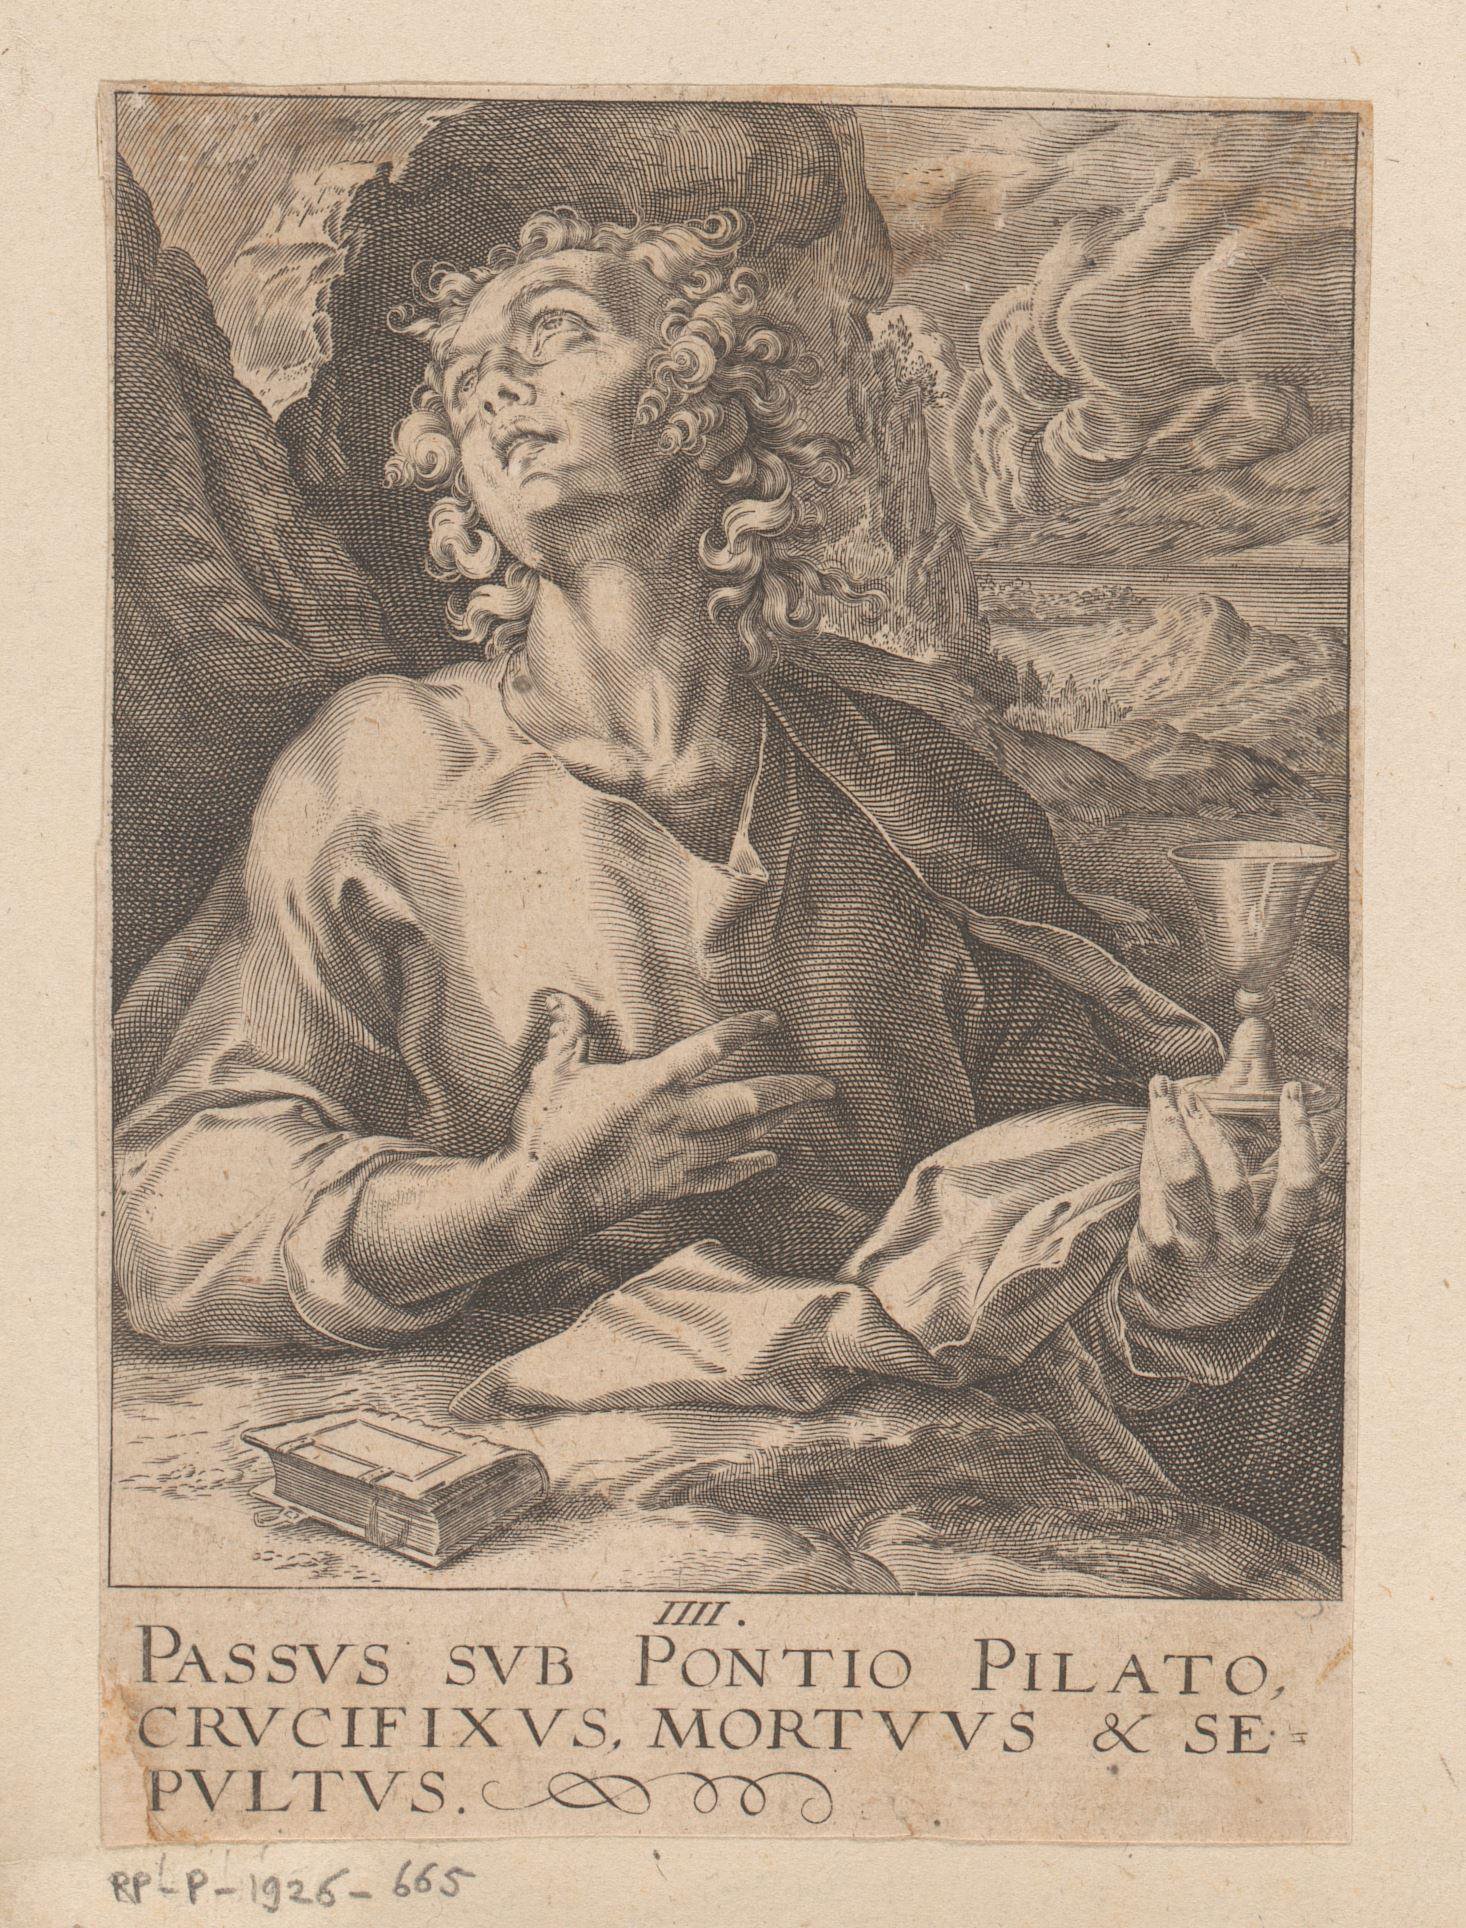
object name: print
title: Apostel Johannes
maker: jacques granthomme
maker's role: print maker, publisher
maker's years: 1550-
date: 1588-1622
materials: paper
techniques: engraving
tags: the apostle john the evangelist; possible attributes: book, cauldron, chalice with snake, eagle, palm, scroll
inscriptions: collector's mark: Lugt 1432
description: Maakt deel uit van een dertiendelige serie van Christus en de twaalf apostelen naar Hendrick Goltzius.